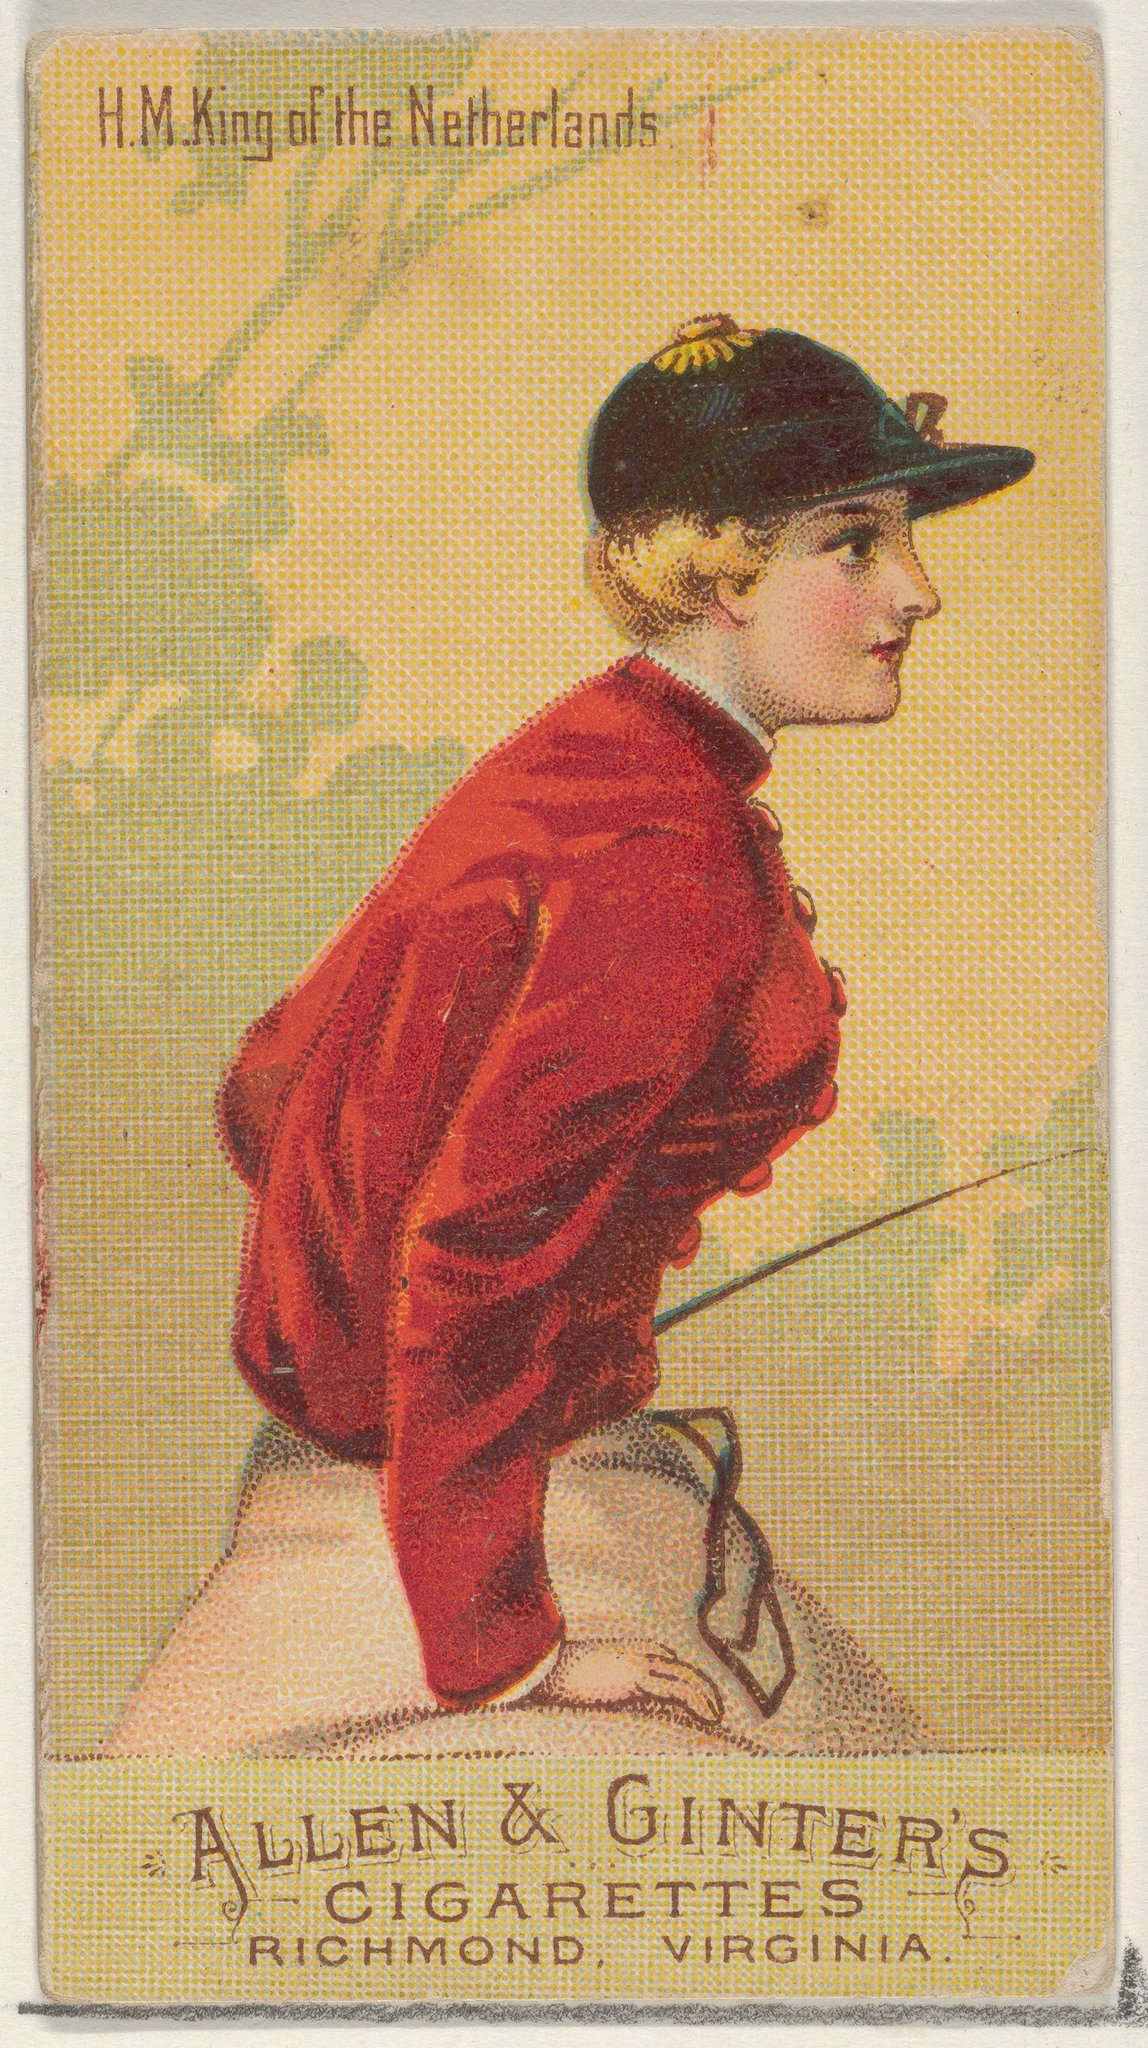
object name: print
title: H.M. King of the Netherlands, from the Racing Colors of the World series (N22b) for Allen & Ginter Cigarettes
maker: allen & ginter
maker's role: publisher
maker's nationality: american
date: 1888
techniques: color lithograph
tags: men,jockeys